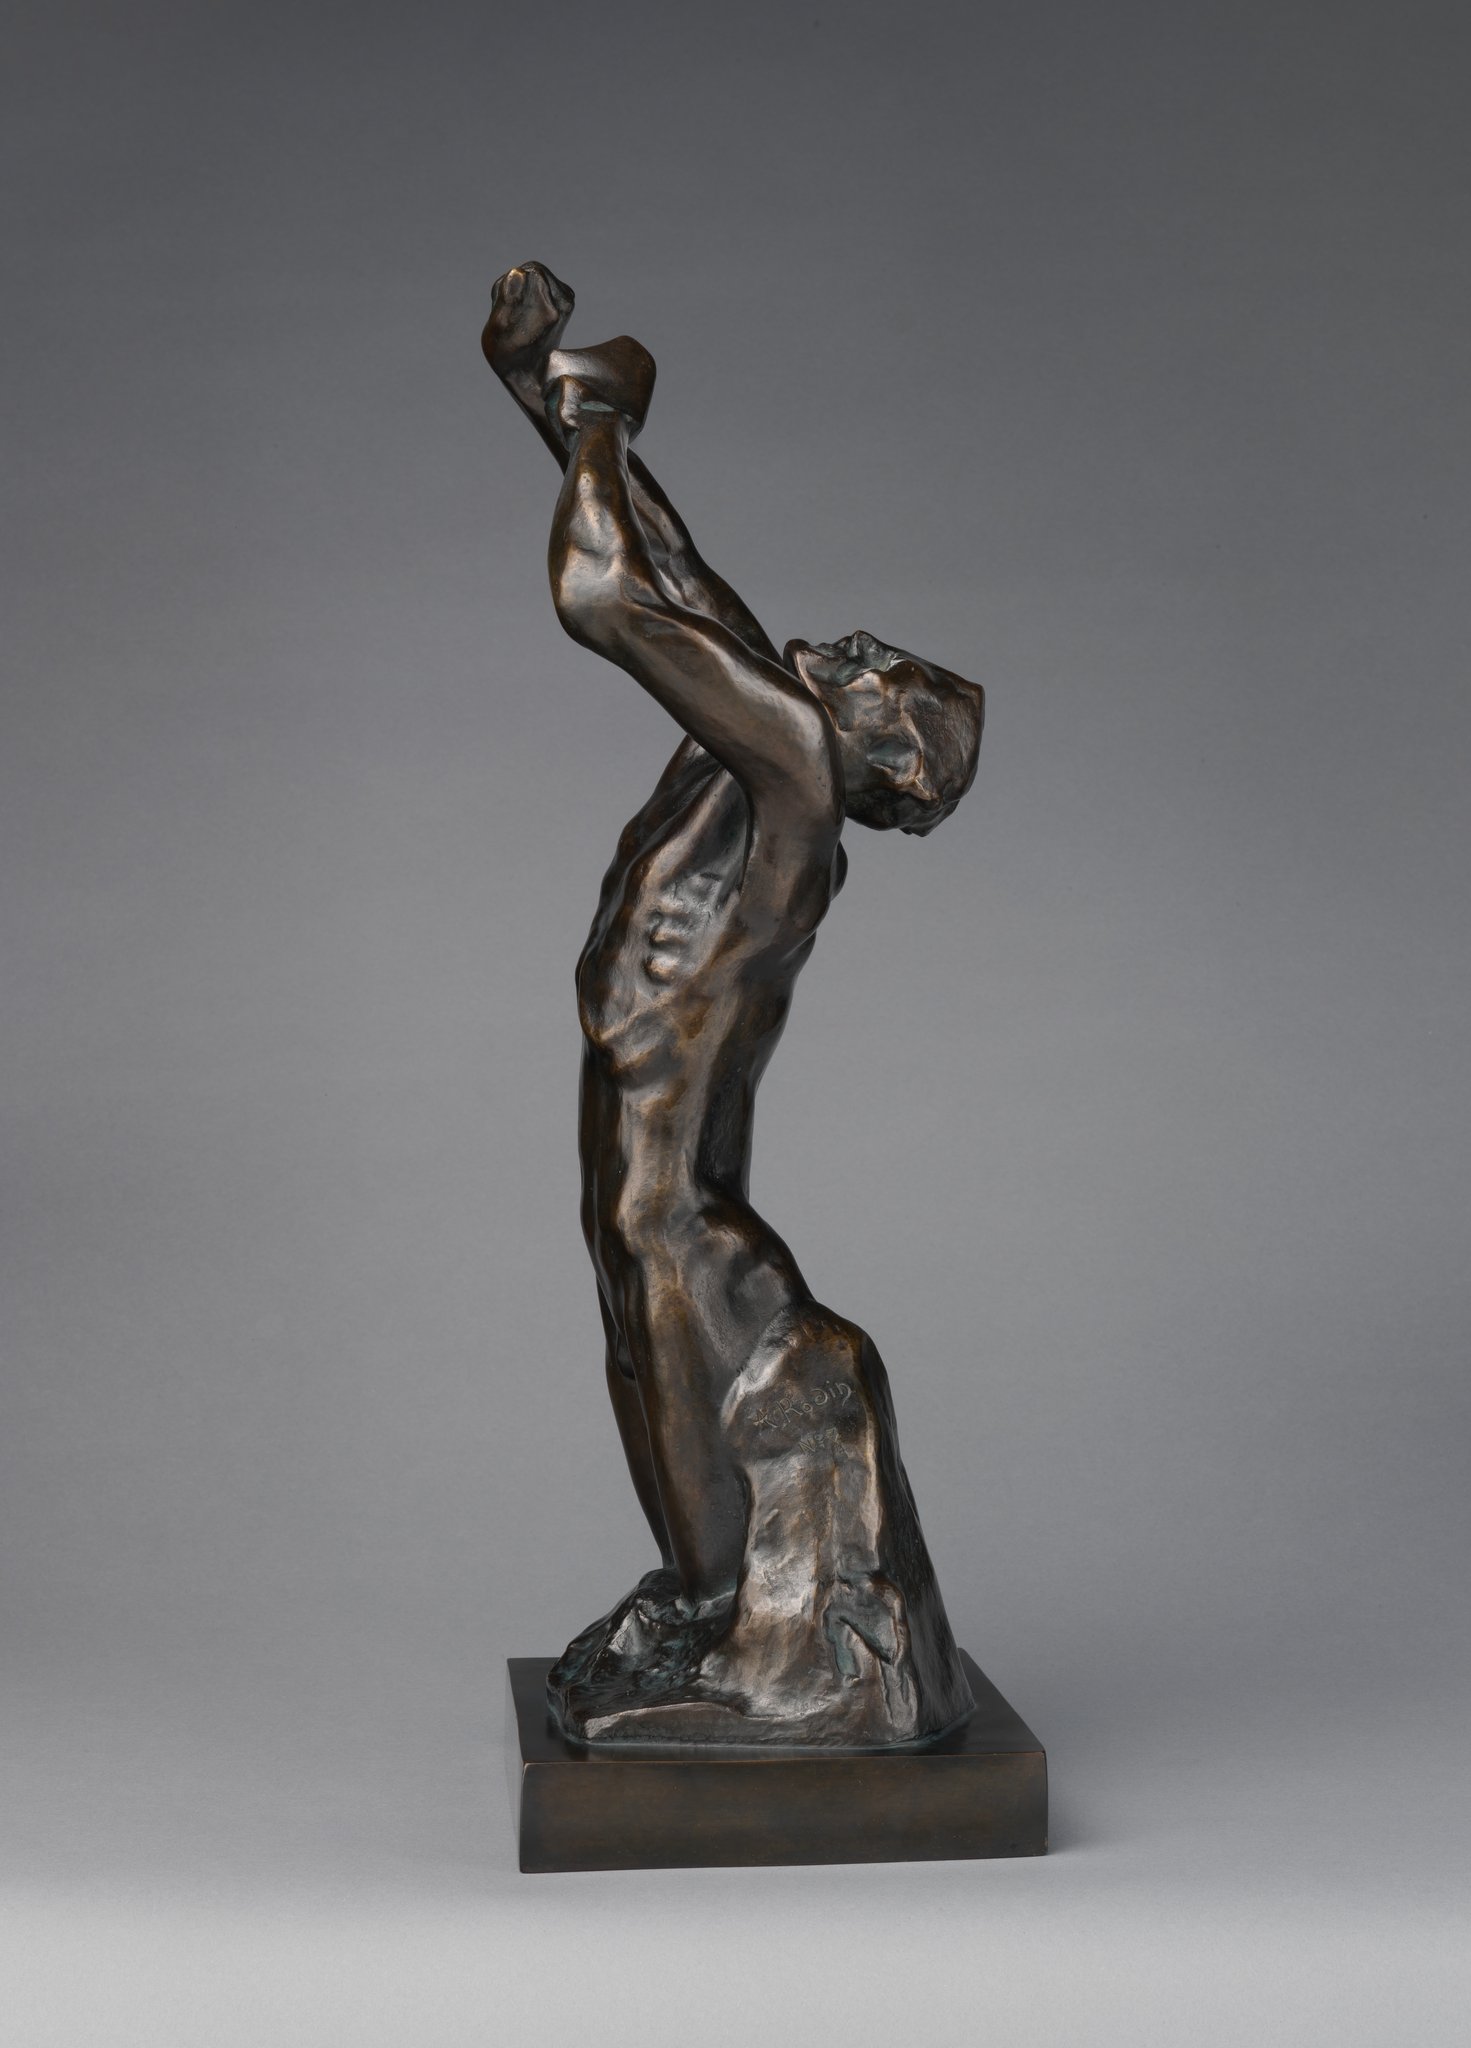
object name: statuette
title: Despairing Adolescent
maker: auguste rodin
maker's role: artist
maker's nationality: french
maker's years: 1840-1917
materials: bronze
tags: men